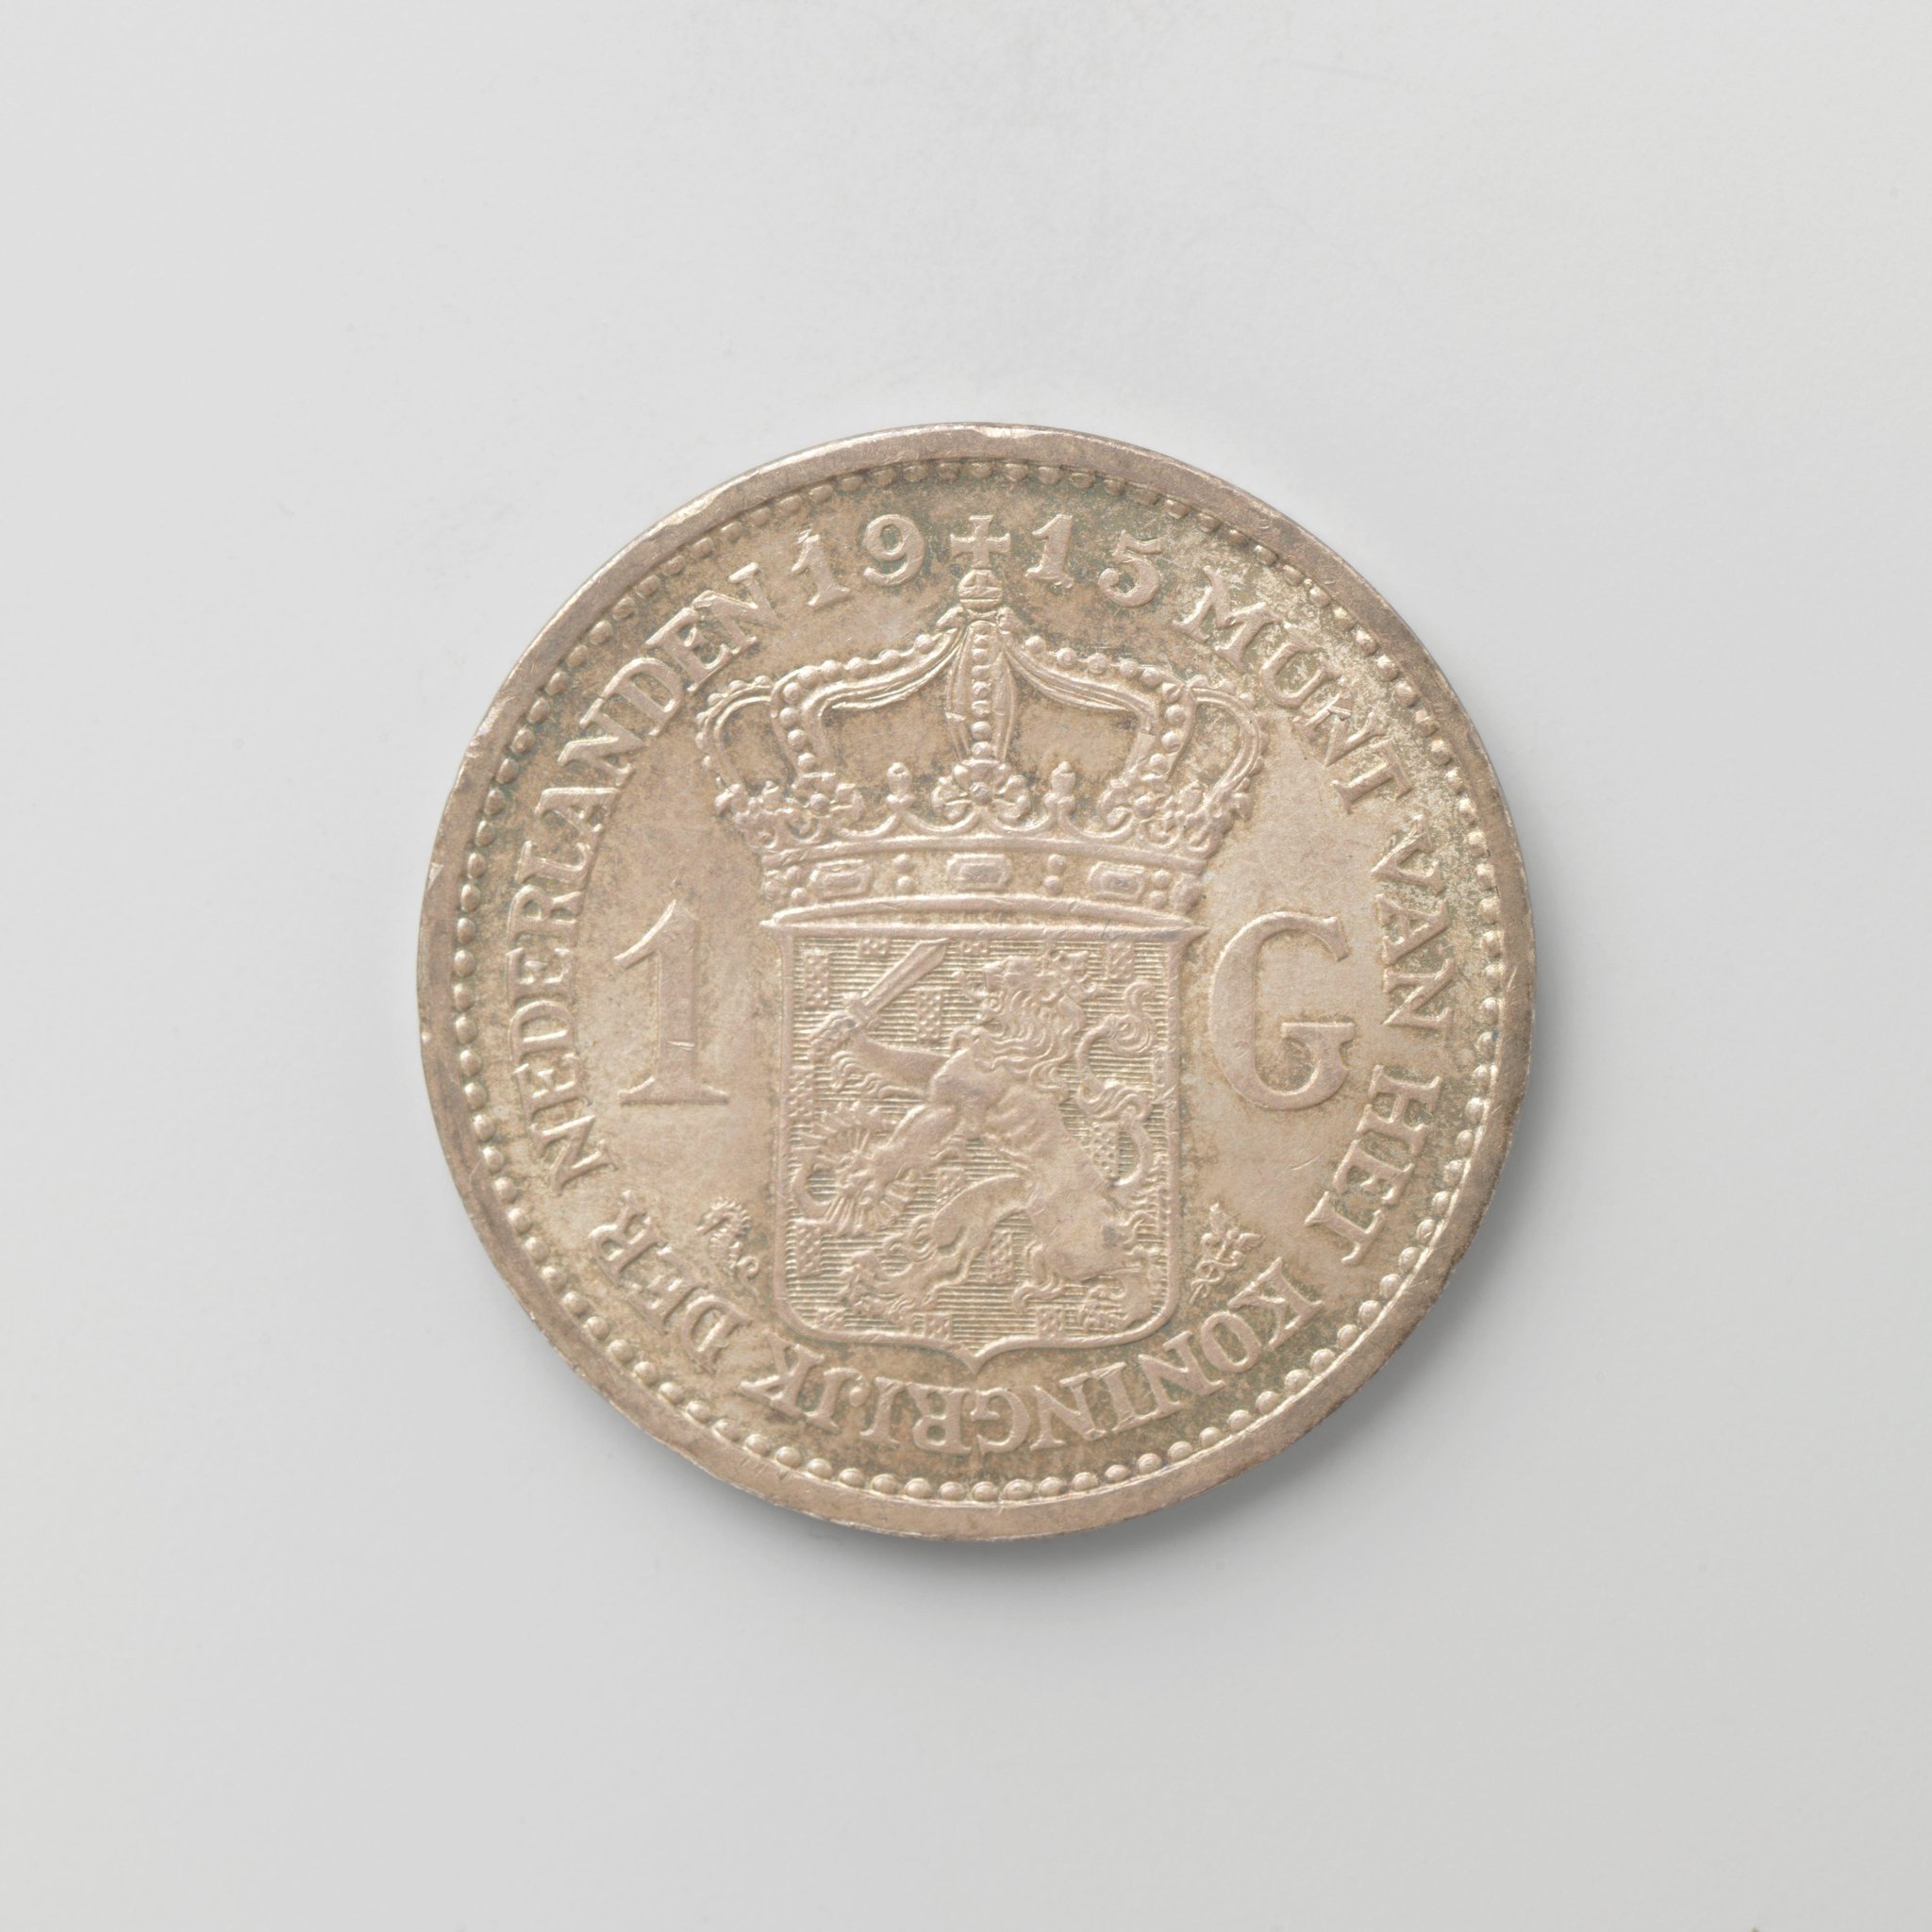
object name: coin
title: Nederland, gulden,1915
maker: wilhelmina of the netherlands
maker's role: print maker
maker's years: 1880-1962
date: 1915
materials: silver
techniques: striking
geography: utrecht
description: Zilveren munt. Voorzijde: gedrapeerd borstbeeld met diadeem naar links. Keerzijde: tussen waarde-aanduiding 1 G gekroond rijkswapenschild. Jaartal bovenaan in omschrift. Randschrift.